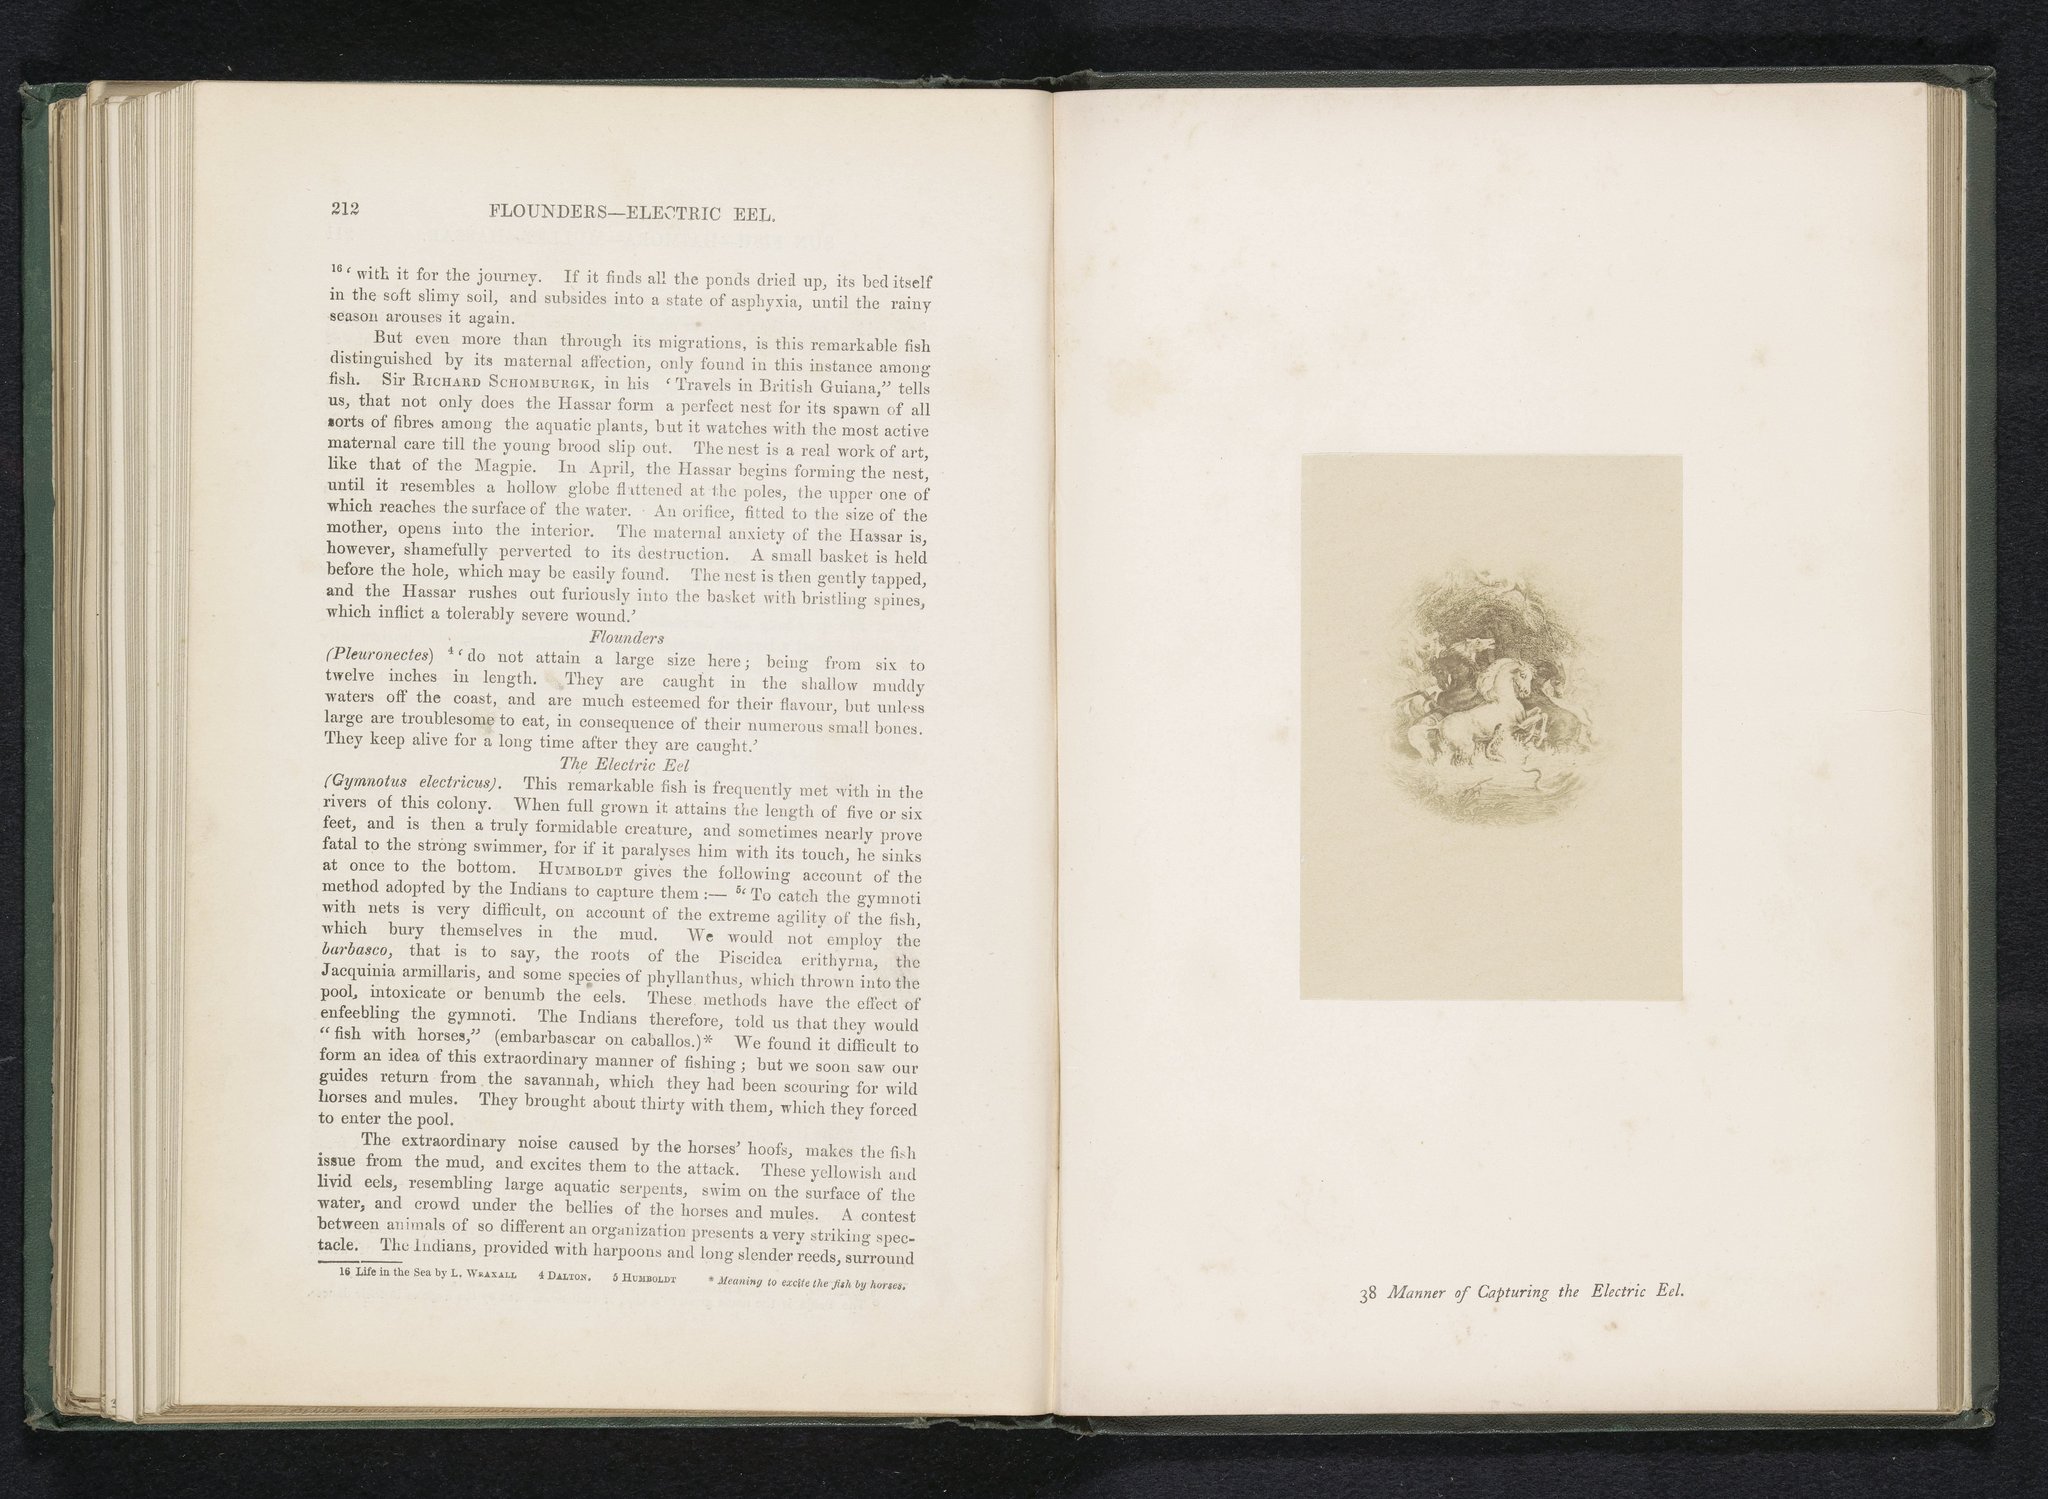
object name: page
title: Fotoreproductie van een tekening van een aal en paarden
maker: Anonymous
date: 1856-1866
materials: photographic support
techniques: albumen print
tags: horse, eels: eel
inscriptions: number: ‘38’